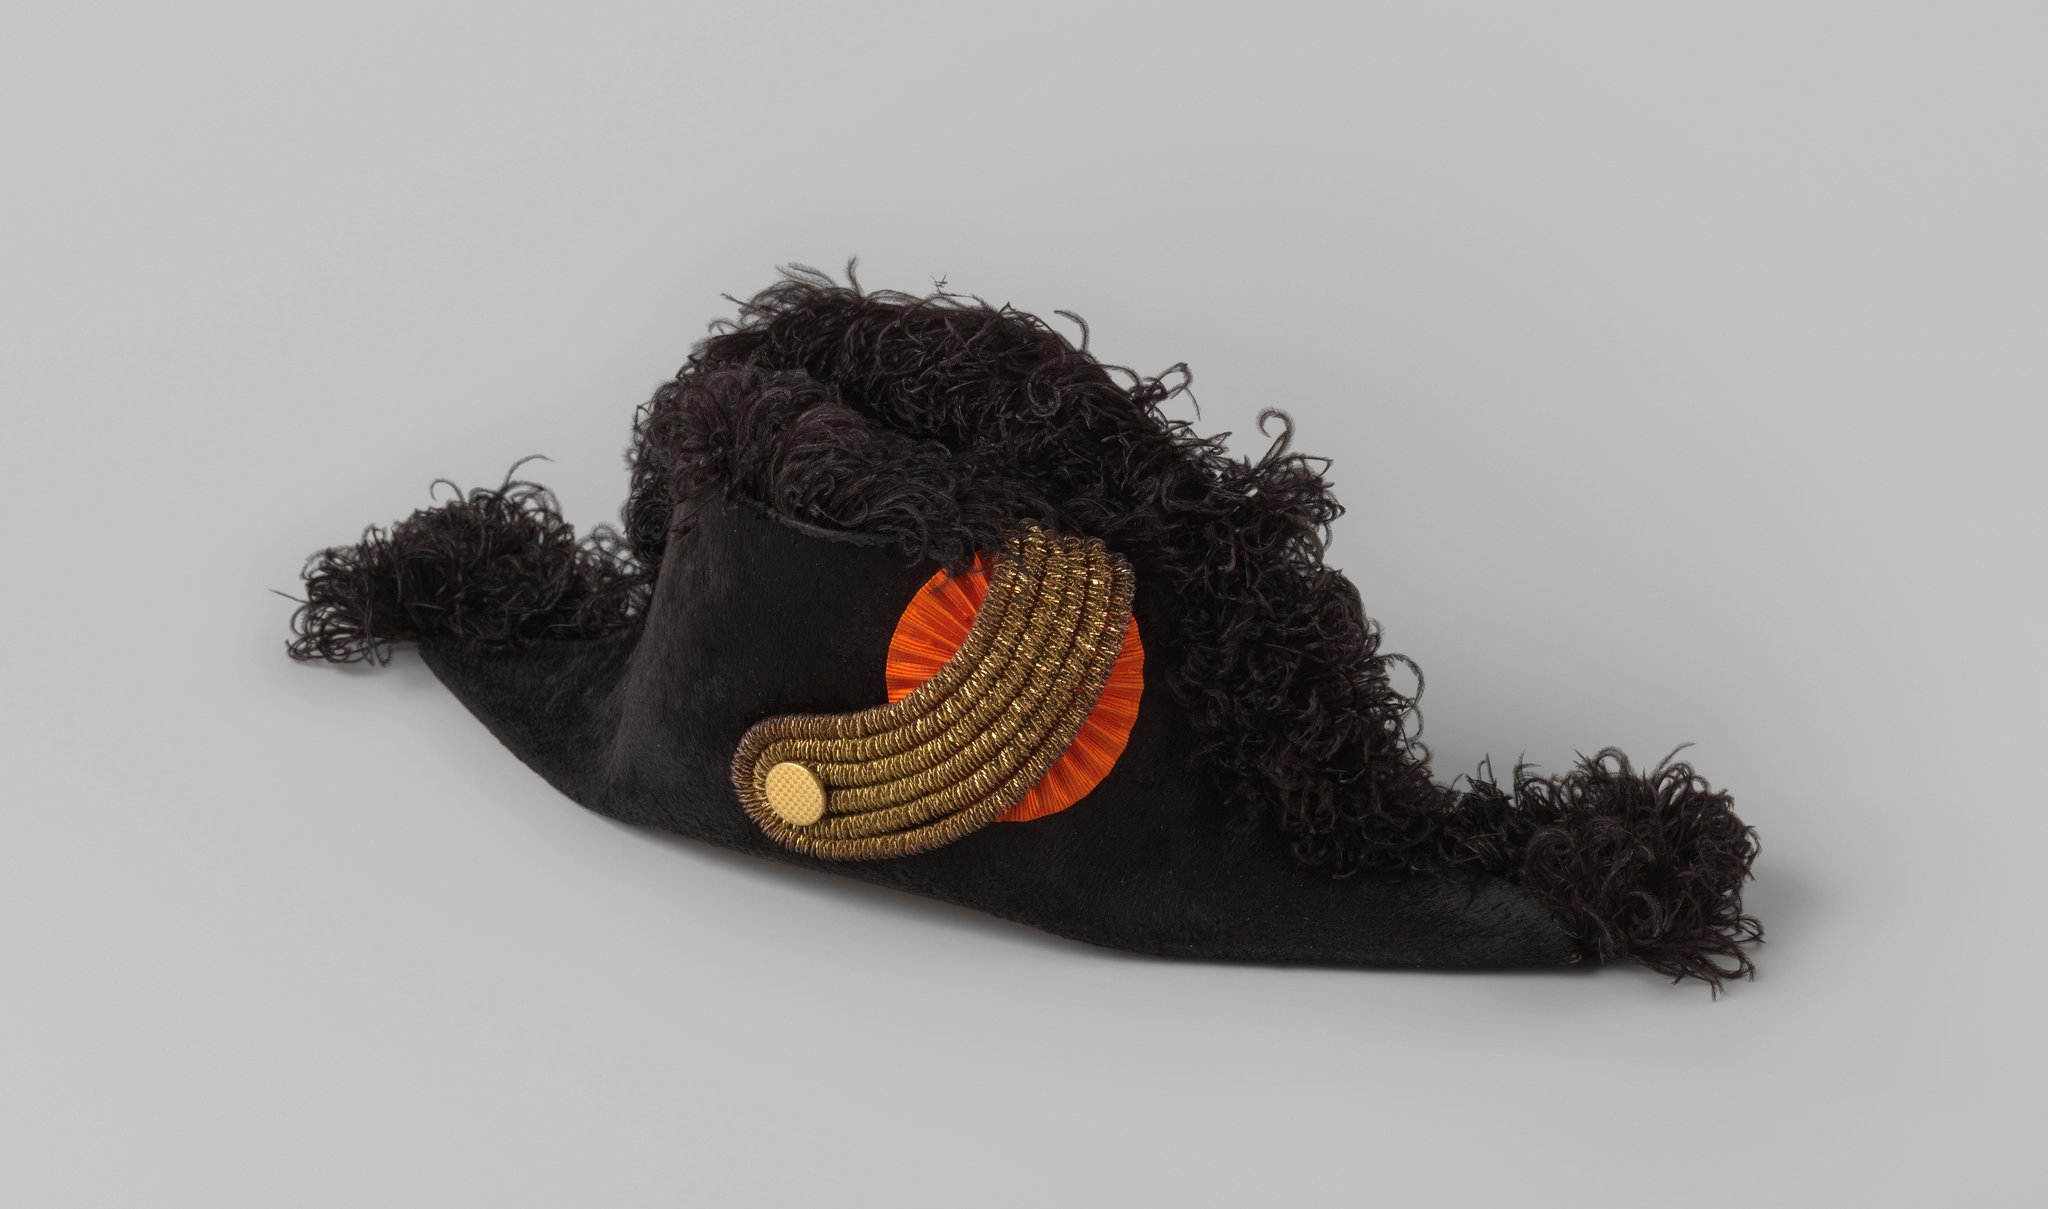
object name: menswear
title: Steek van zwart vilt, versierd met zwarte struisveren, goudkleurige lis en oranje kokarde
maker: isaäc johannes froger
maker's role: hoedenmaker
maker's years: 1781-1843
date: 1800-1850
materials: copper, felt, leather, metal thread, textile, silk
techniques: tanning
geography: amsterdam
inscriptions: company name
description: Steek van zwart vilt. Model: bicorne. Entrée van naturelkleurig leer. Voering van wit satijn. Crèmekleurig satijnen strikje. Versiering: afgezet met korte, zwarte struisveren. Aan de rechterzijde lis van gouddraad over oranje kokarde. Knoop met blokpatroon. Adres (ingeplakt; in goud op wit satijn): I.J. FROGER// AND SON // AMSTERDAM (onder Engelse "standardbearers").Tussen hoedband en voering visitekaartje van P. VAN EEGHEN.